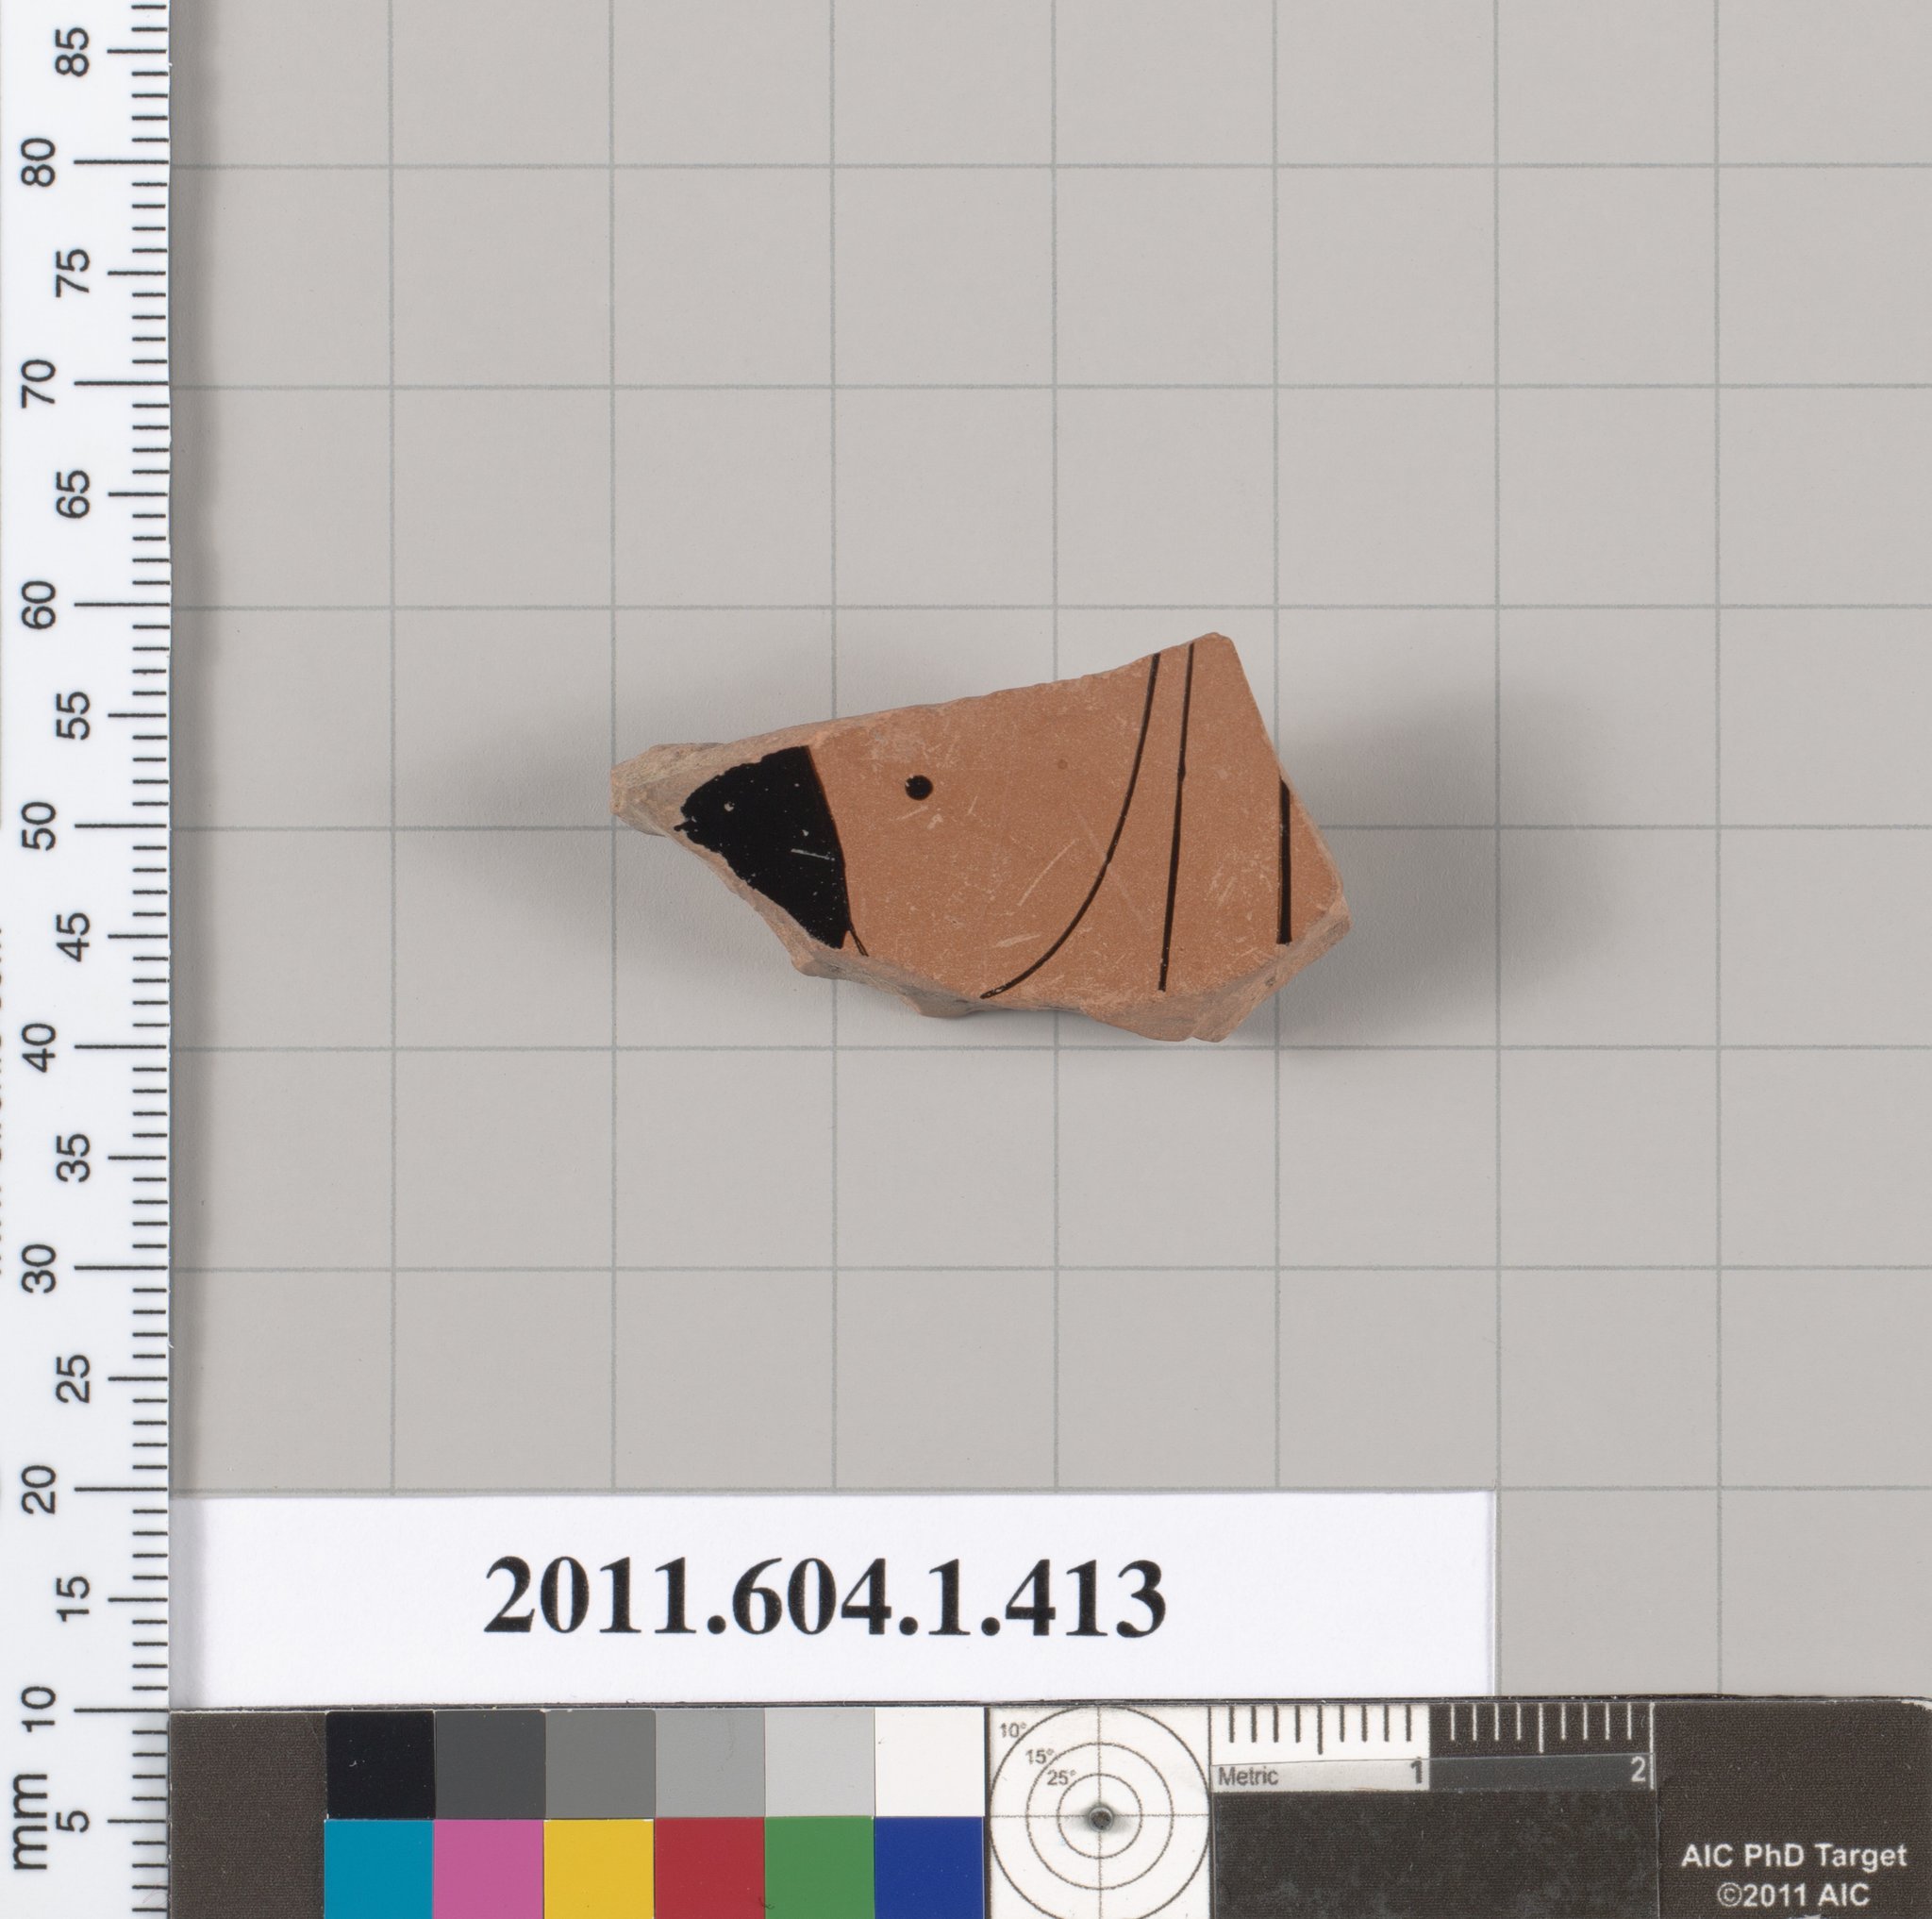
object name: kylix fragment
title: Terracotta fragment of a kylix (drinking cup)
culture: greek, attic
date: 475-451 BCE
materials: terracotta